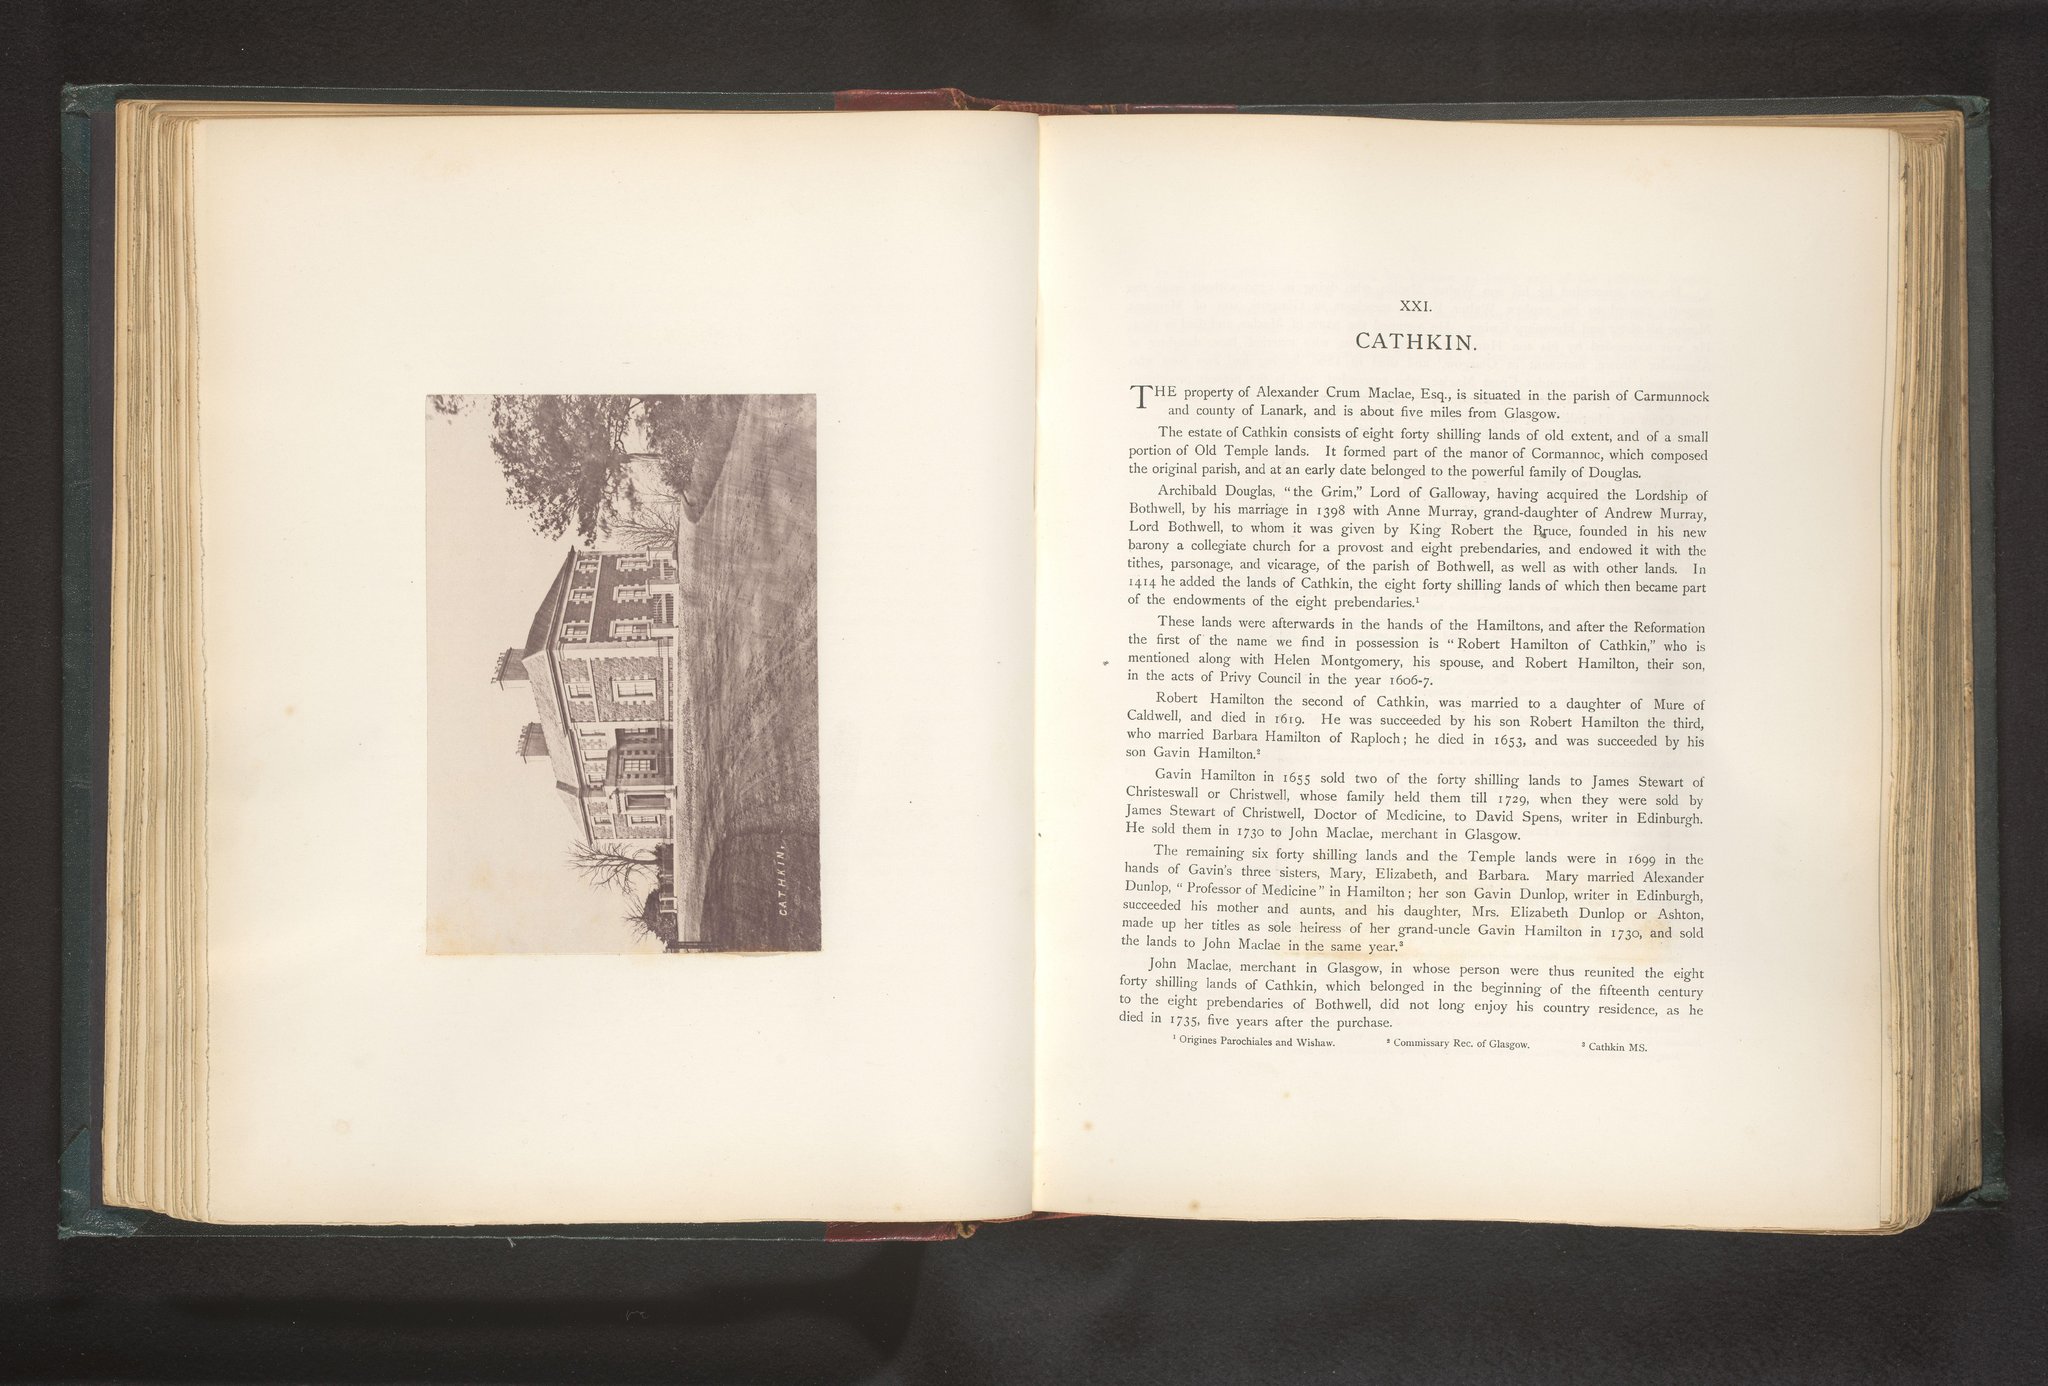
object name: page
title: Cathkin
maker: thomas annan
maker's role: fotograaf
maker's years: 1829-1887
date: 1868-1878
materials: paper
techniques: carbon print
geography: lanarkshire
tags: rural housing, e.g. country-house, villa, cottage, façade (of house or building)